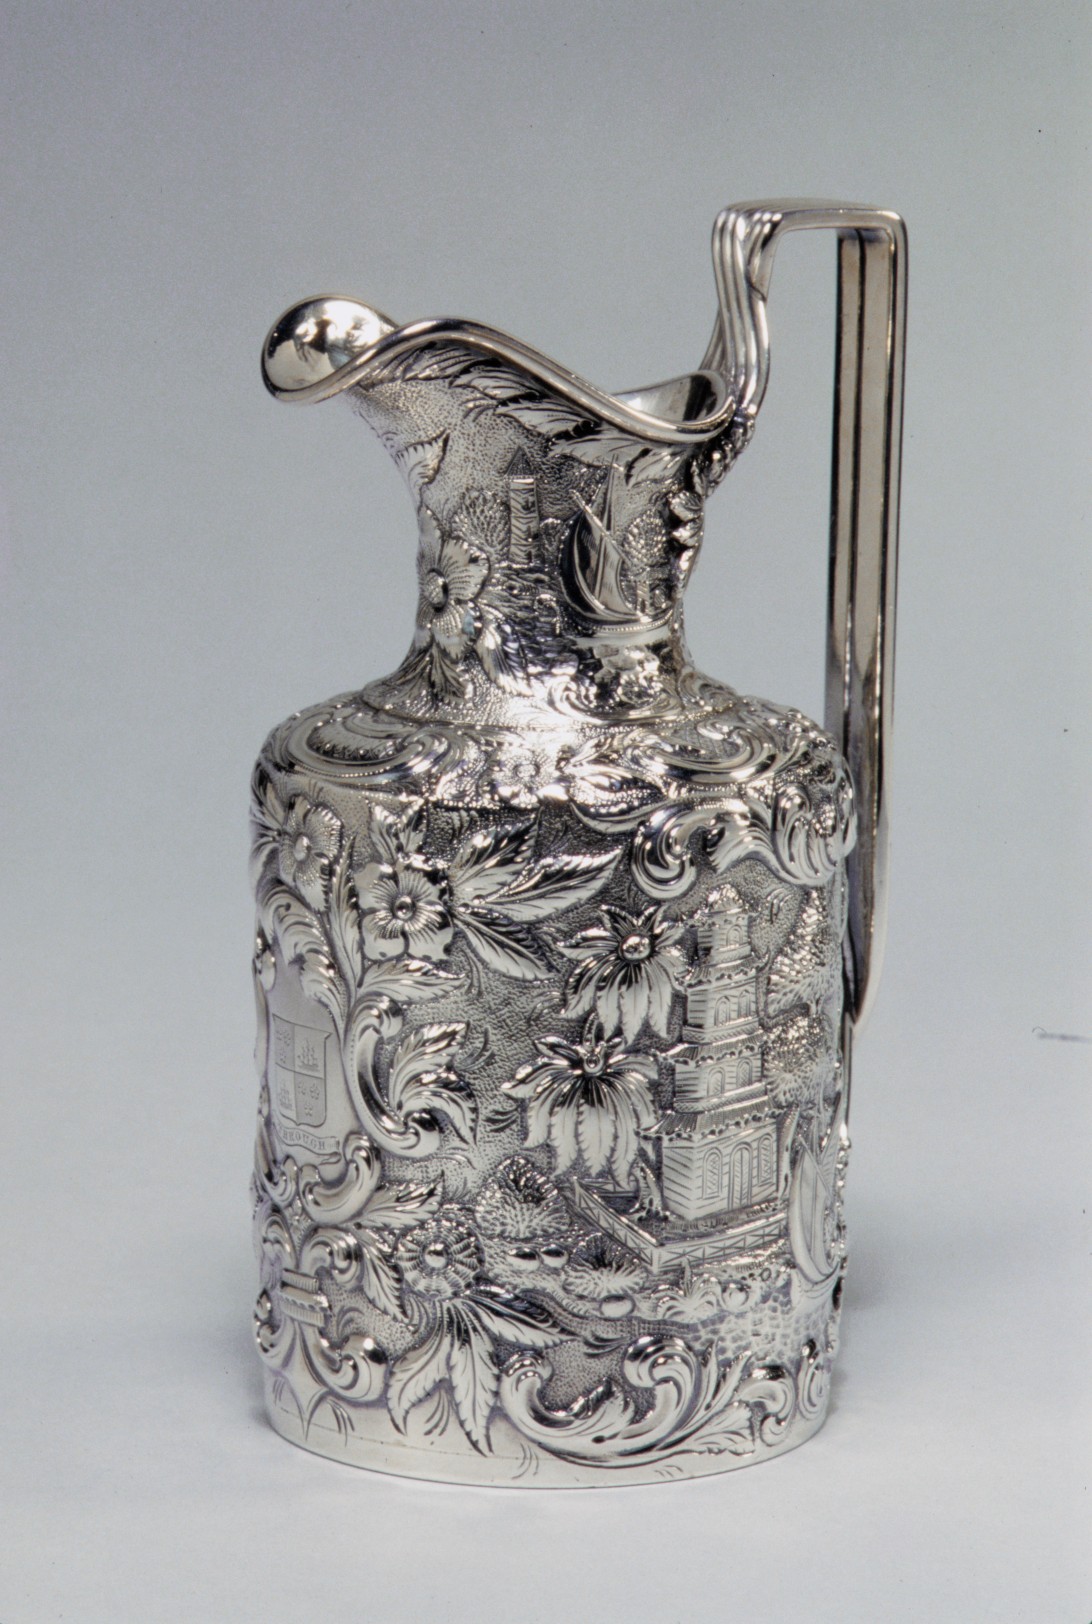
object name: cream pot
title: Creampot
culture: american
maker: andrew ellicott warner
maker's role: maker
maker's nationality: american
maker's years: 1786-1870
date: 1845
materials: silver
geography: united states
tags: flowers,coat of arms